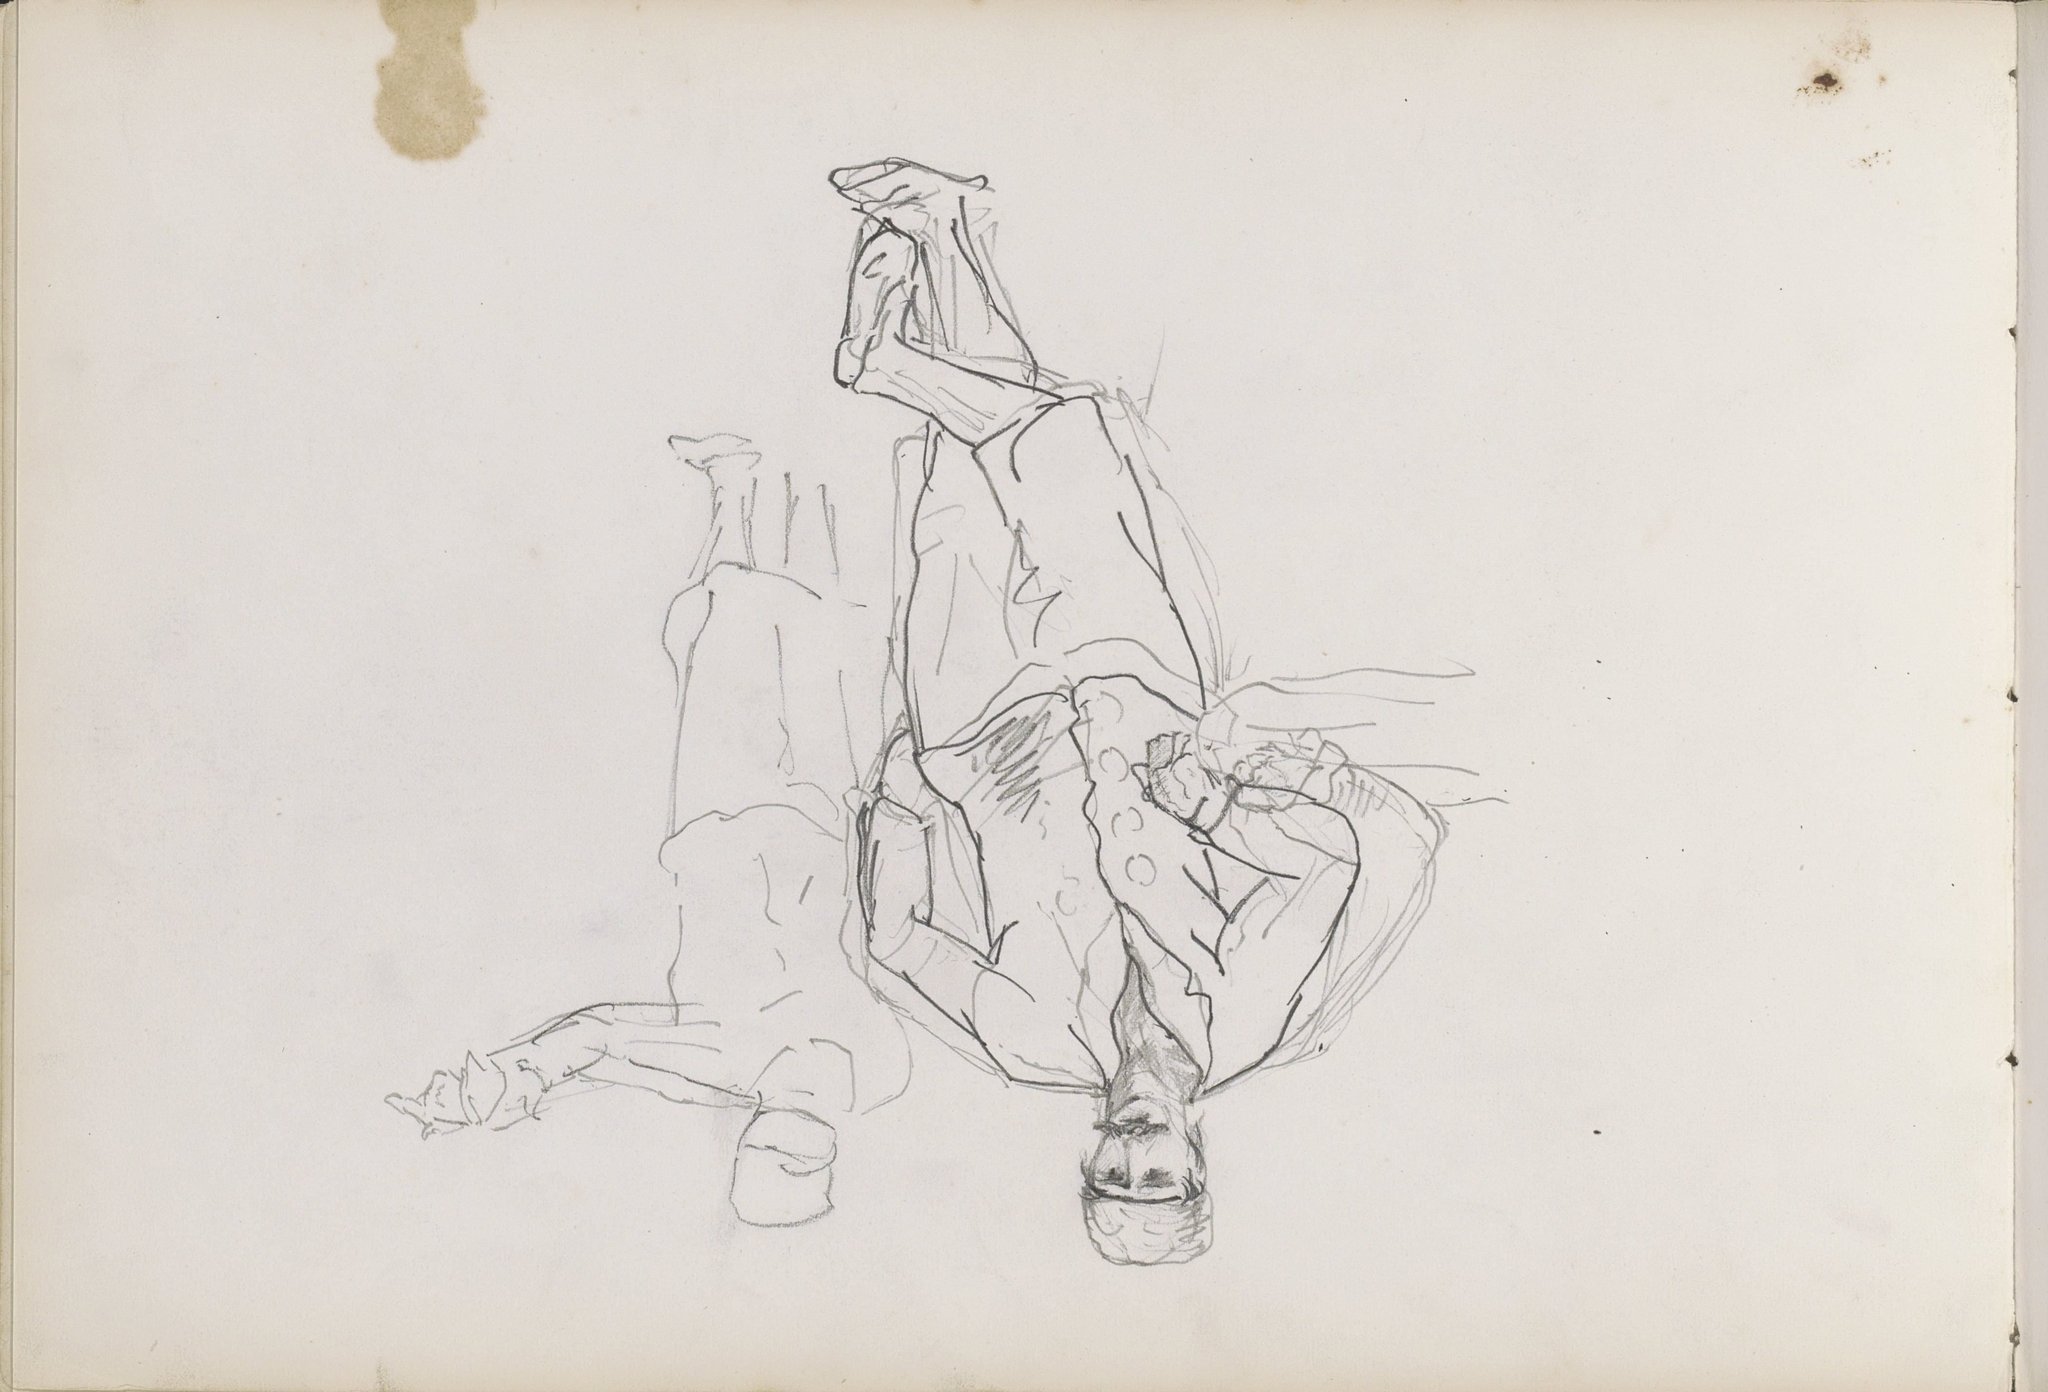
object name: sketchbook leaf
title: Voor- en achteraanzicht van een staande man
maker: george hendrik breitner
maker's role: draughtsman, painter, print maker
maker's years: 1857-1923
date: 1873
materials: paper, pencil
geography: rotterdam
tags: standing figure (+ front view), standing figure (+ back view)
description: Blad 16 verso uit een schetsboek met 25 bladen.